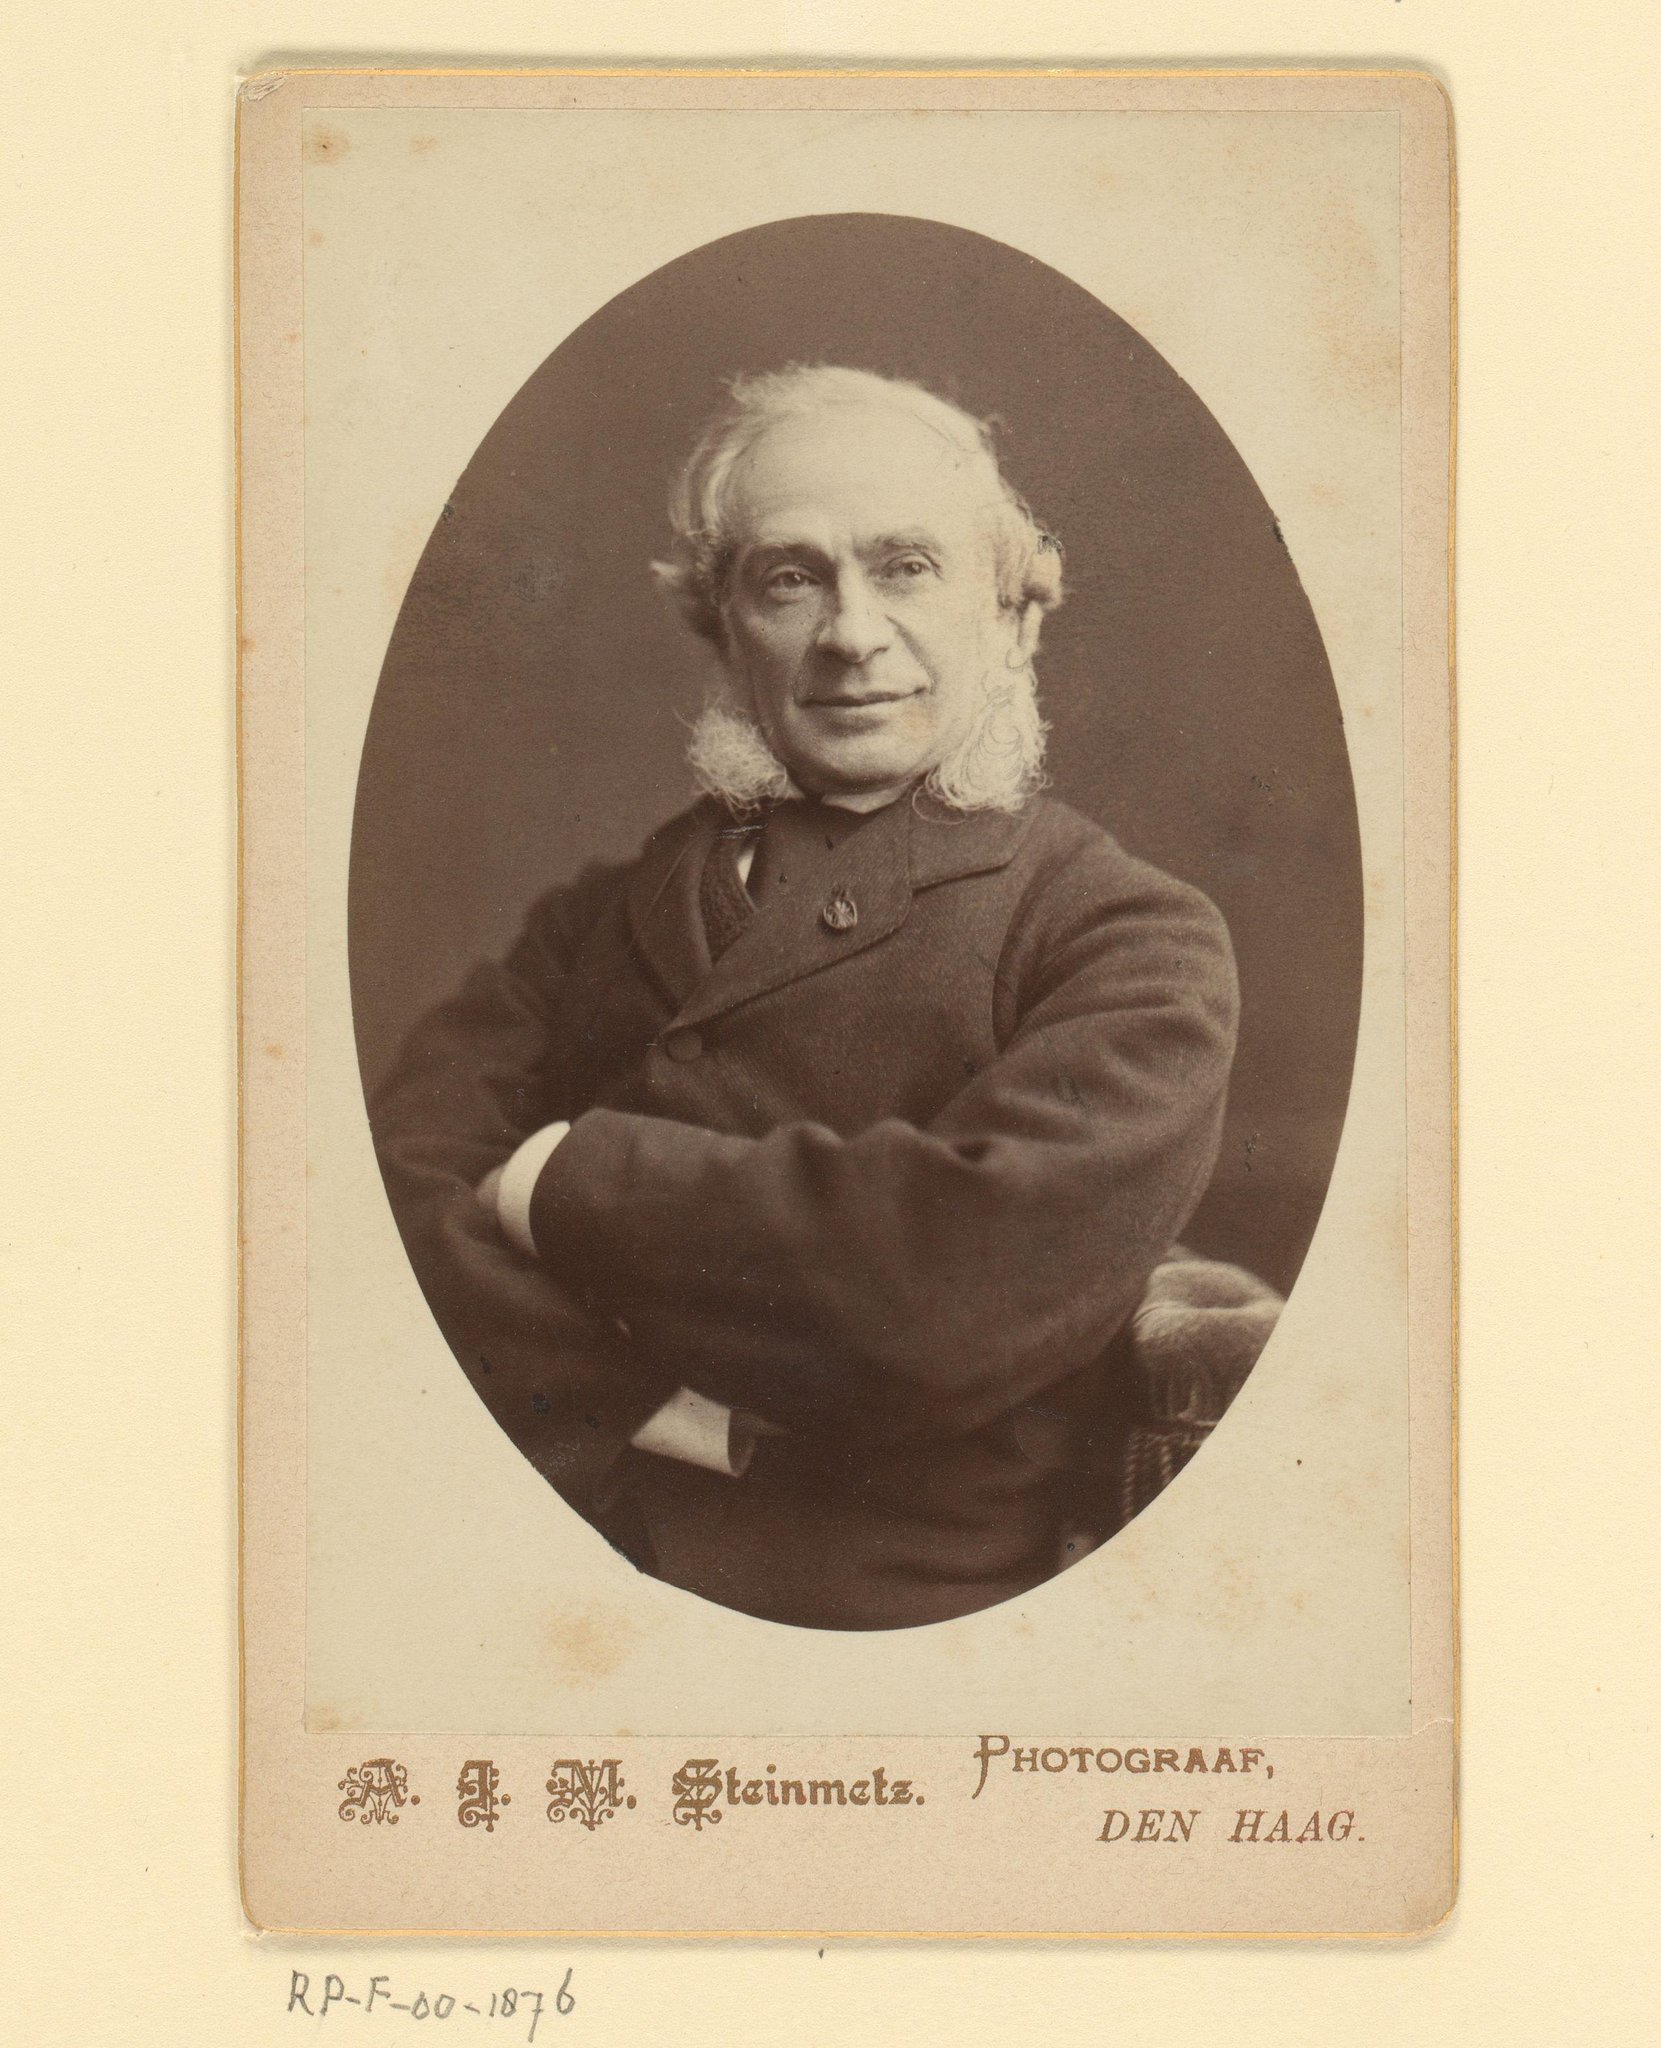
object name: photograph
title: Portret van de schilder David Bles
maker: antoine johan marinus steinmetz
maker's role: fotograaf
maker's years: 1867-1950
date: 1890-1895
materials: cardboard, paper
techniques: albumen print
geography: the hague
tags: the hague, painter, print maker, draughtsman, david bles, historical persons, portrait, self-portrait of painter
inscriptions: inscription: ‘David Jozef Bles/ Kunstschilder/ 1821-1899’